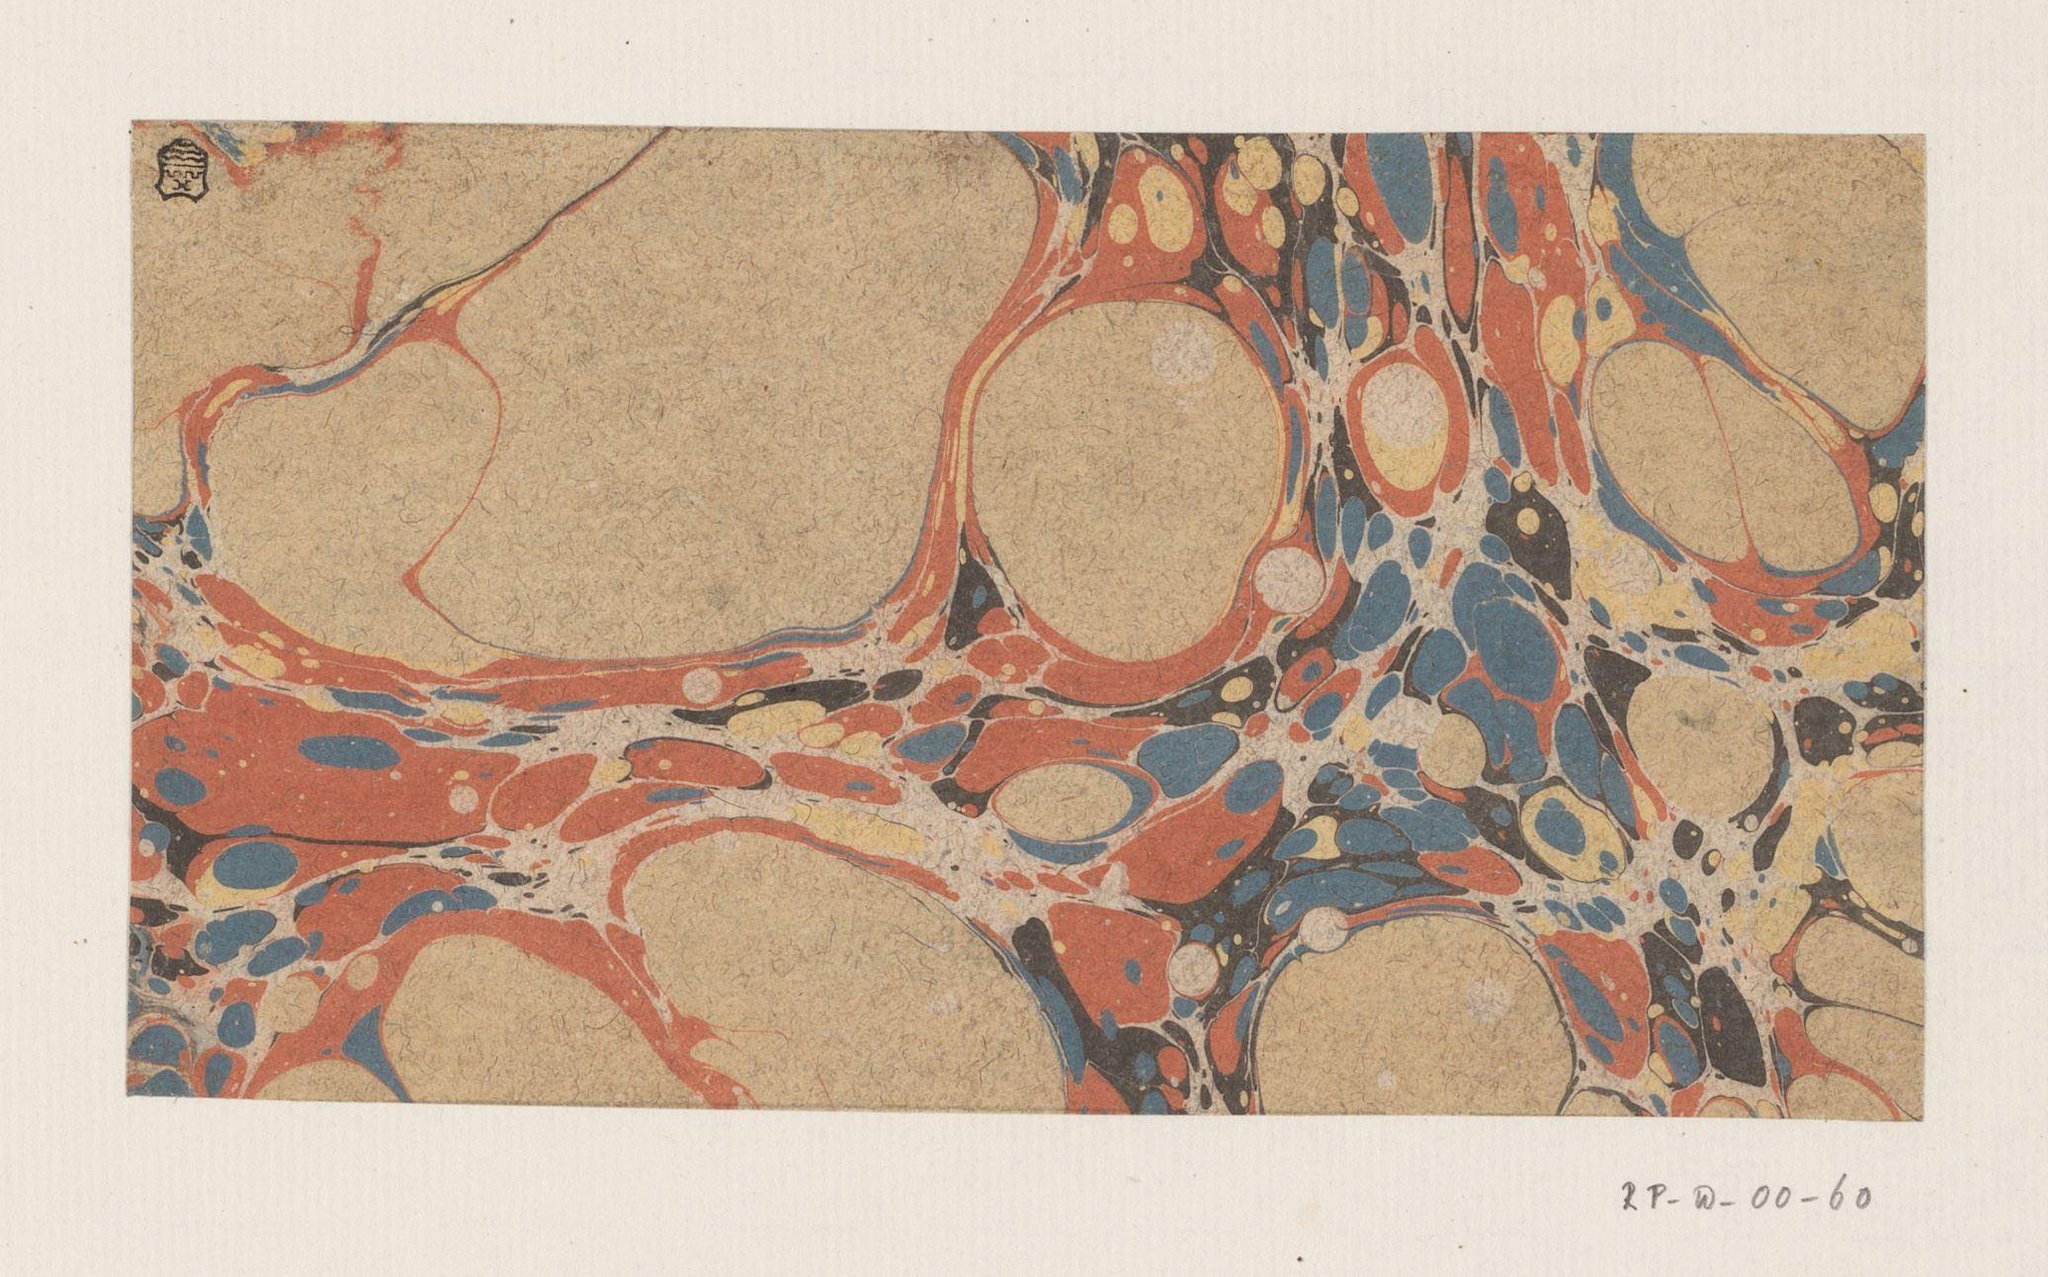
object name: marbled paper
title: Kiezelmarmer in oranje, geel en blauw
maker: Anonymous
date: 1700-1850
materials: paint, paper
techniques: marbling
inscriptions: collector's mark: Lugt 2760